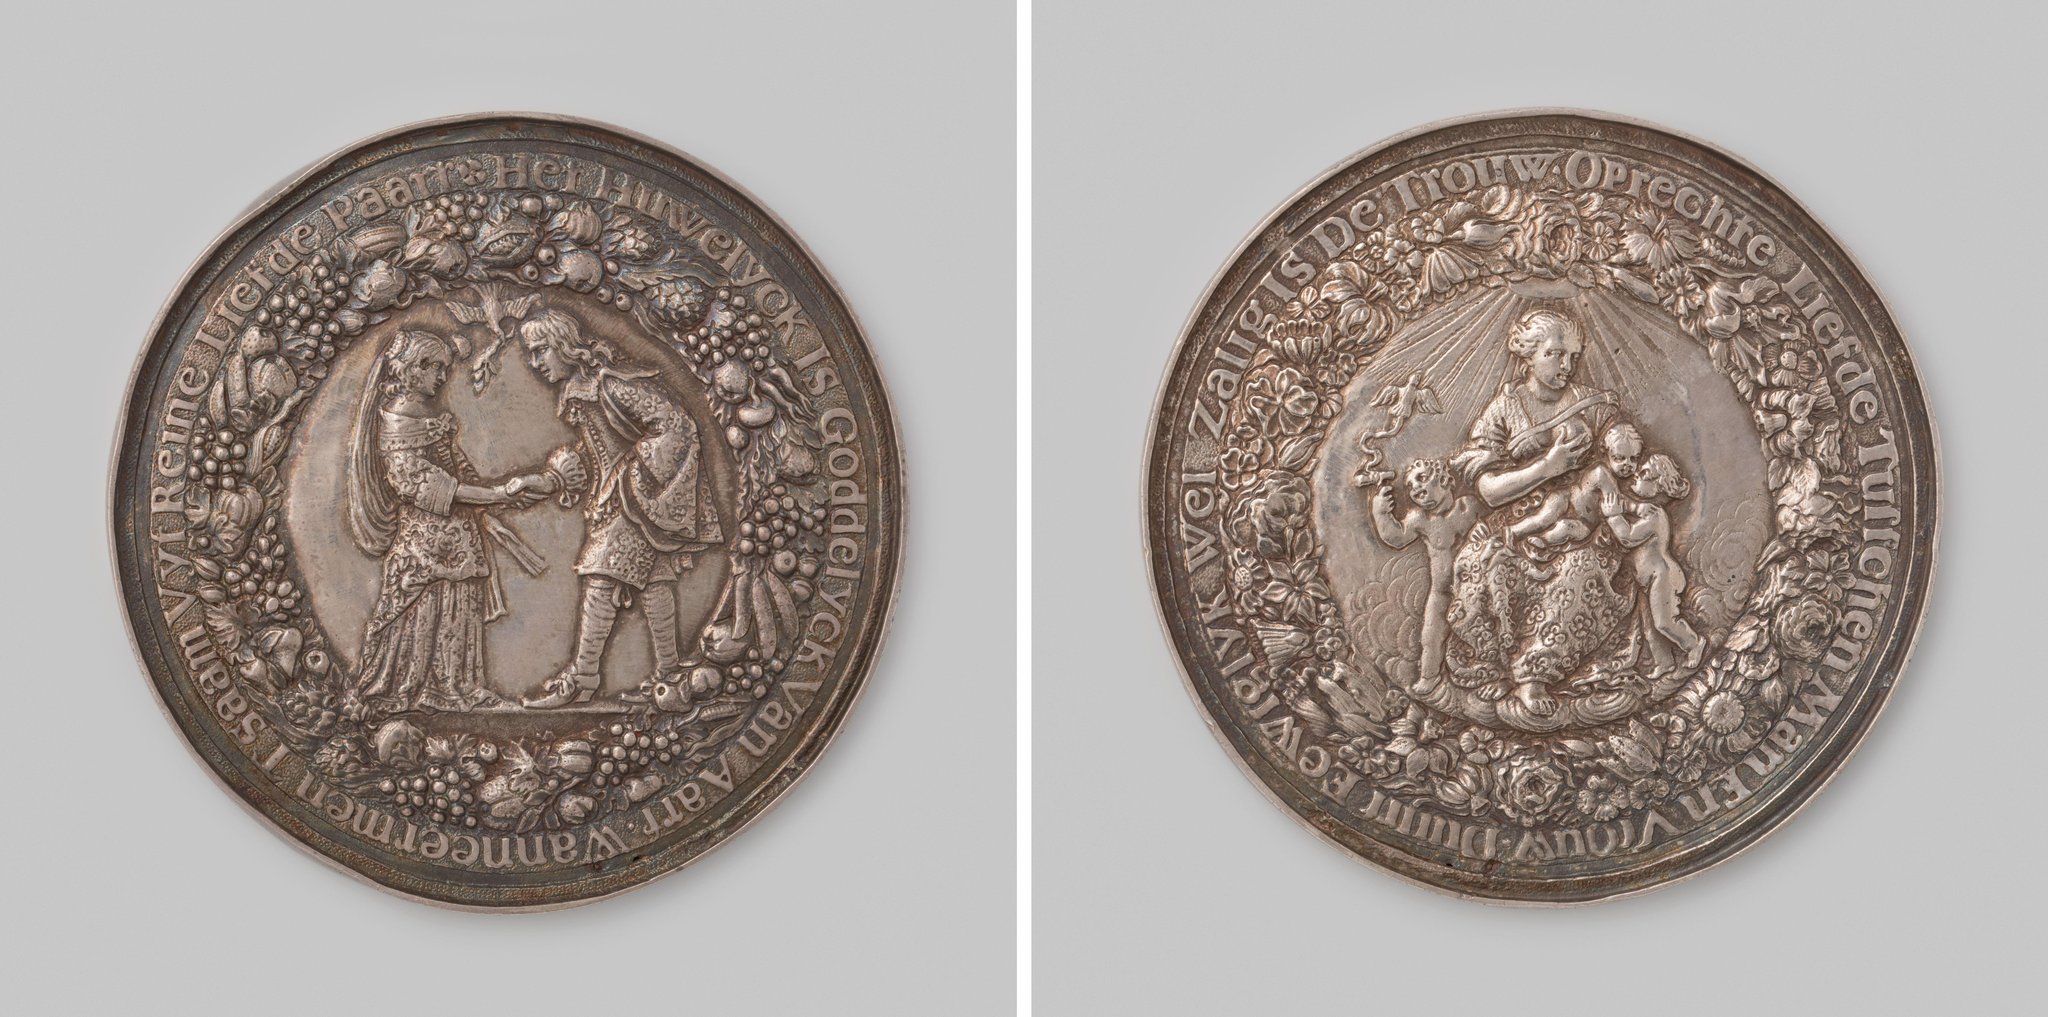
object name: family medal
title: Anonieme huwelijkspenning (1650)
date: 1650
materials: silver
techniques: casting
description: Grote zilveren penning met aangesoldeerde rand, op de voorzijde binnen een krans van bloemen en vruchten een jongen die een meisje de hand drukt, met omschrift, op de keerzijde binnen een krans met bloemen een zogende vrouw met drie kinderen, met omschrift.